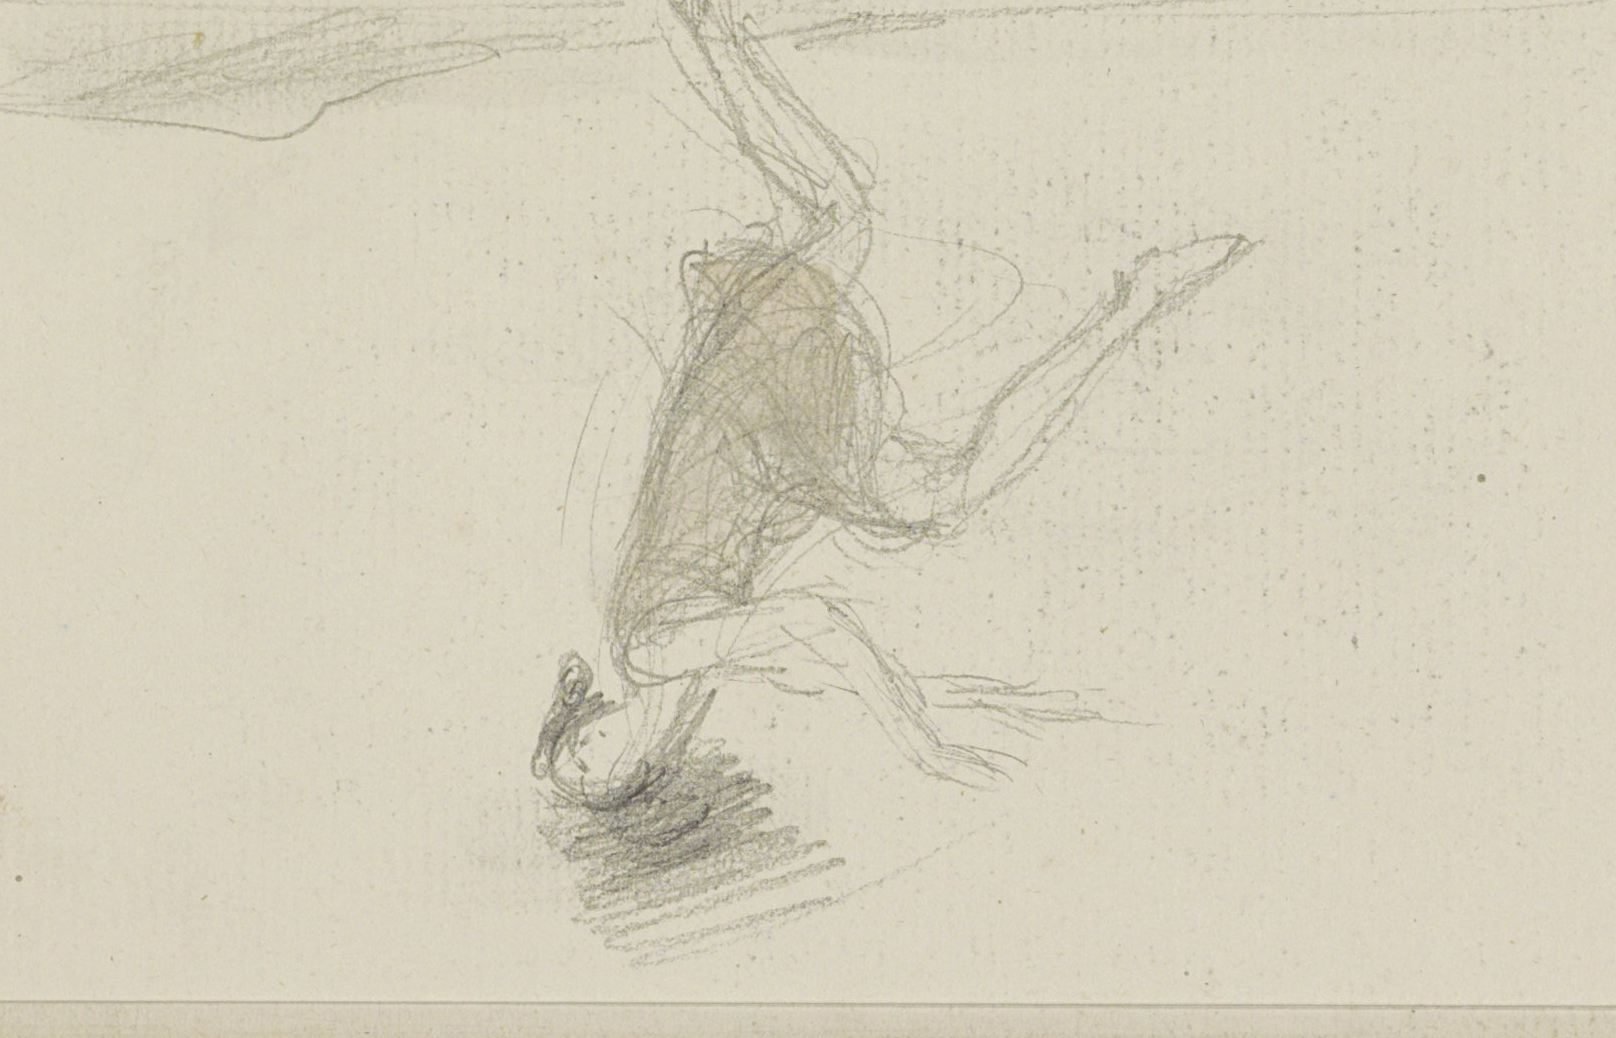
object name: sketchbook leaf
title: Dansende vrouw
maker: marius bauer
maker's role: draughtsman, print maker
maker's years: 1867-1932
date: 1902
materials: paper, pencil, watercolor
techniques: brush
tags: woman dancing alone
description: Pagina 51 uit een schetsboek met 30 bladen.